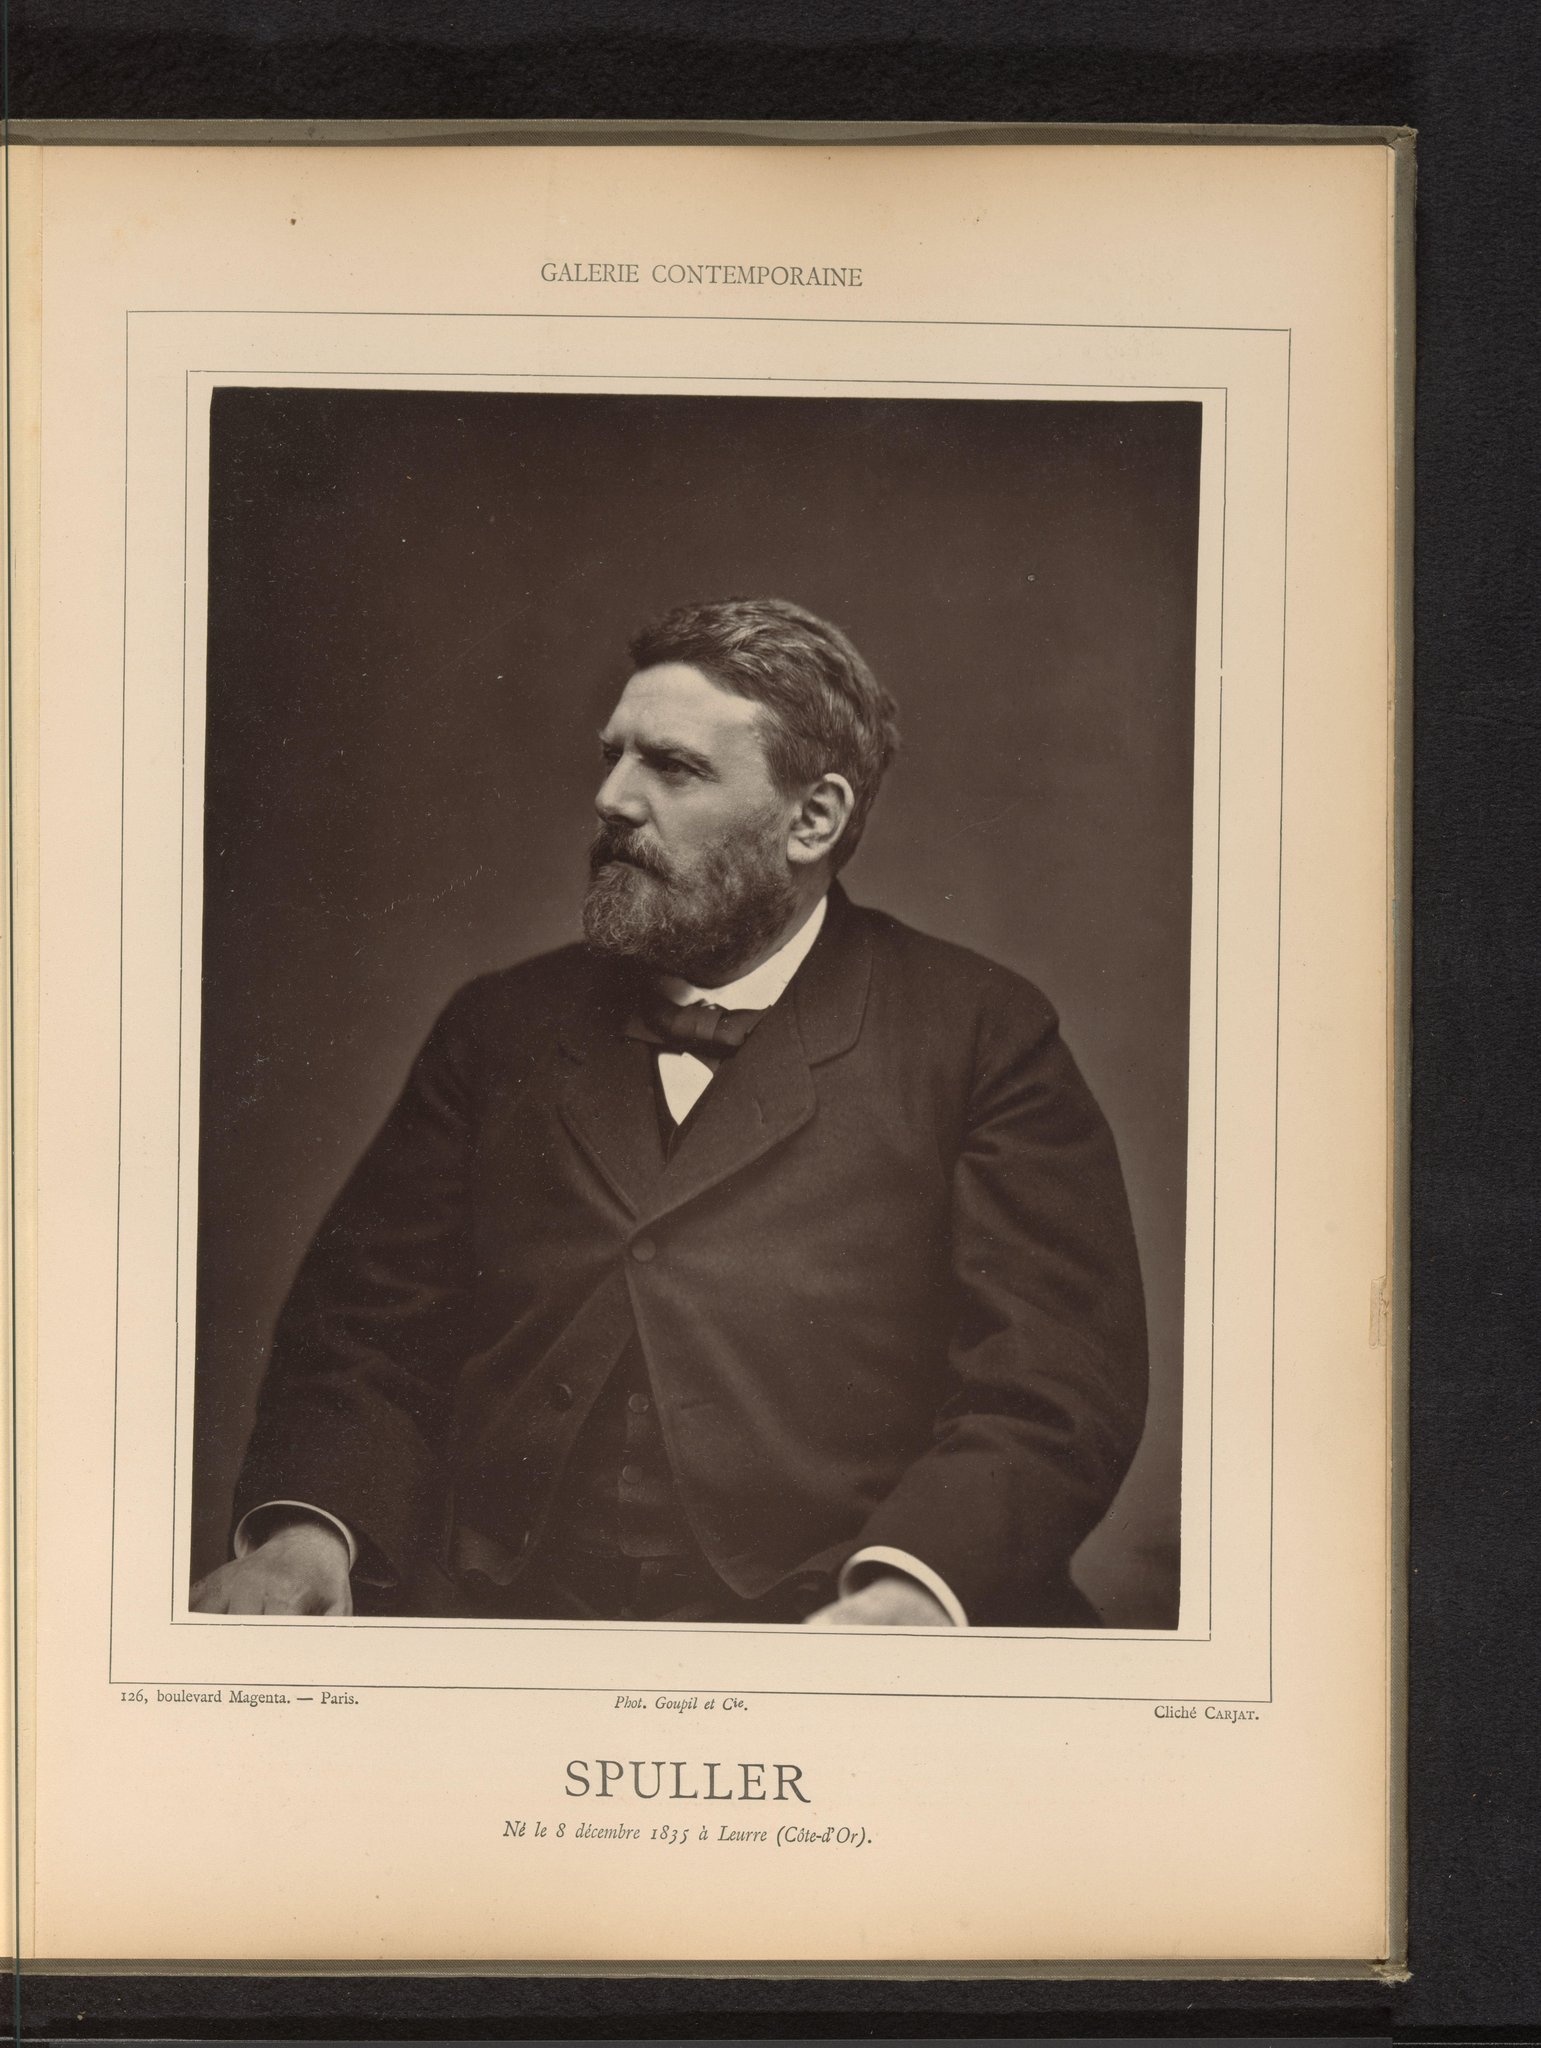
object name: page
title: Portret van Eugène Spuller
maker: étienne carjat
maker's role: draughtsman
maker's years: 1828-1906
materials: paper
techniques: woodburytype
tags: politician, historical persons, politician, e.g. party leader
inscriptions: address: ‘126, boulevard Magenta. - Paris.’, inscription: ‘Né le 8 décembre 1835 à Leurre (Côte-d'Or).’